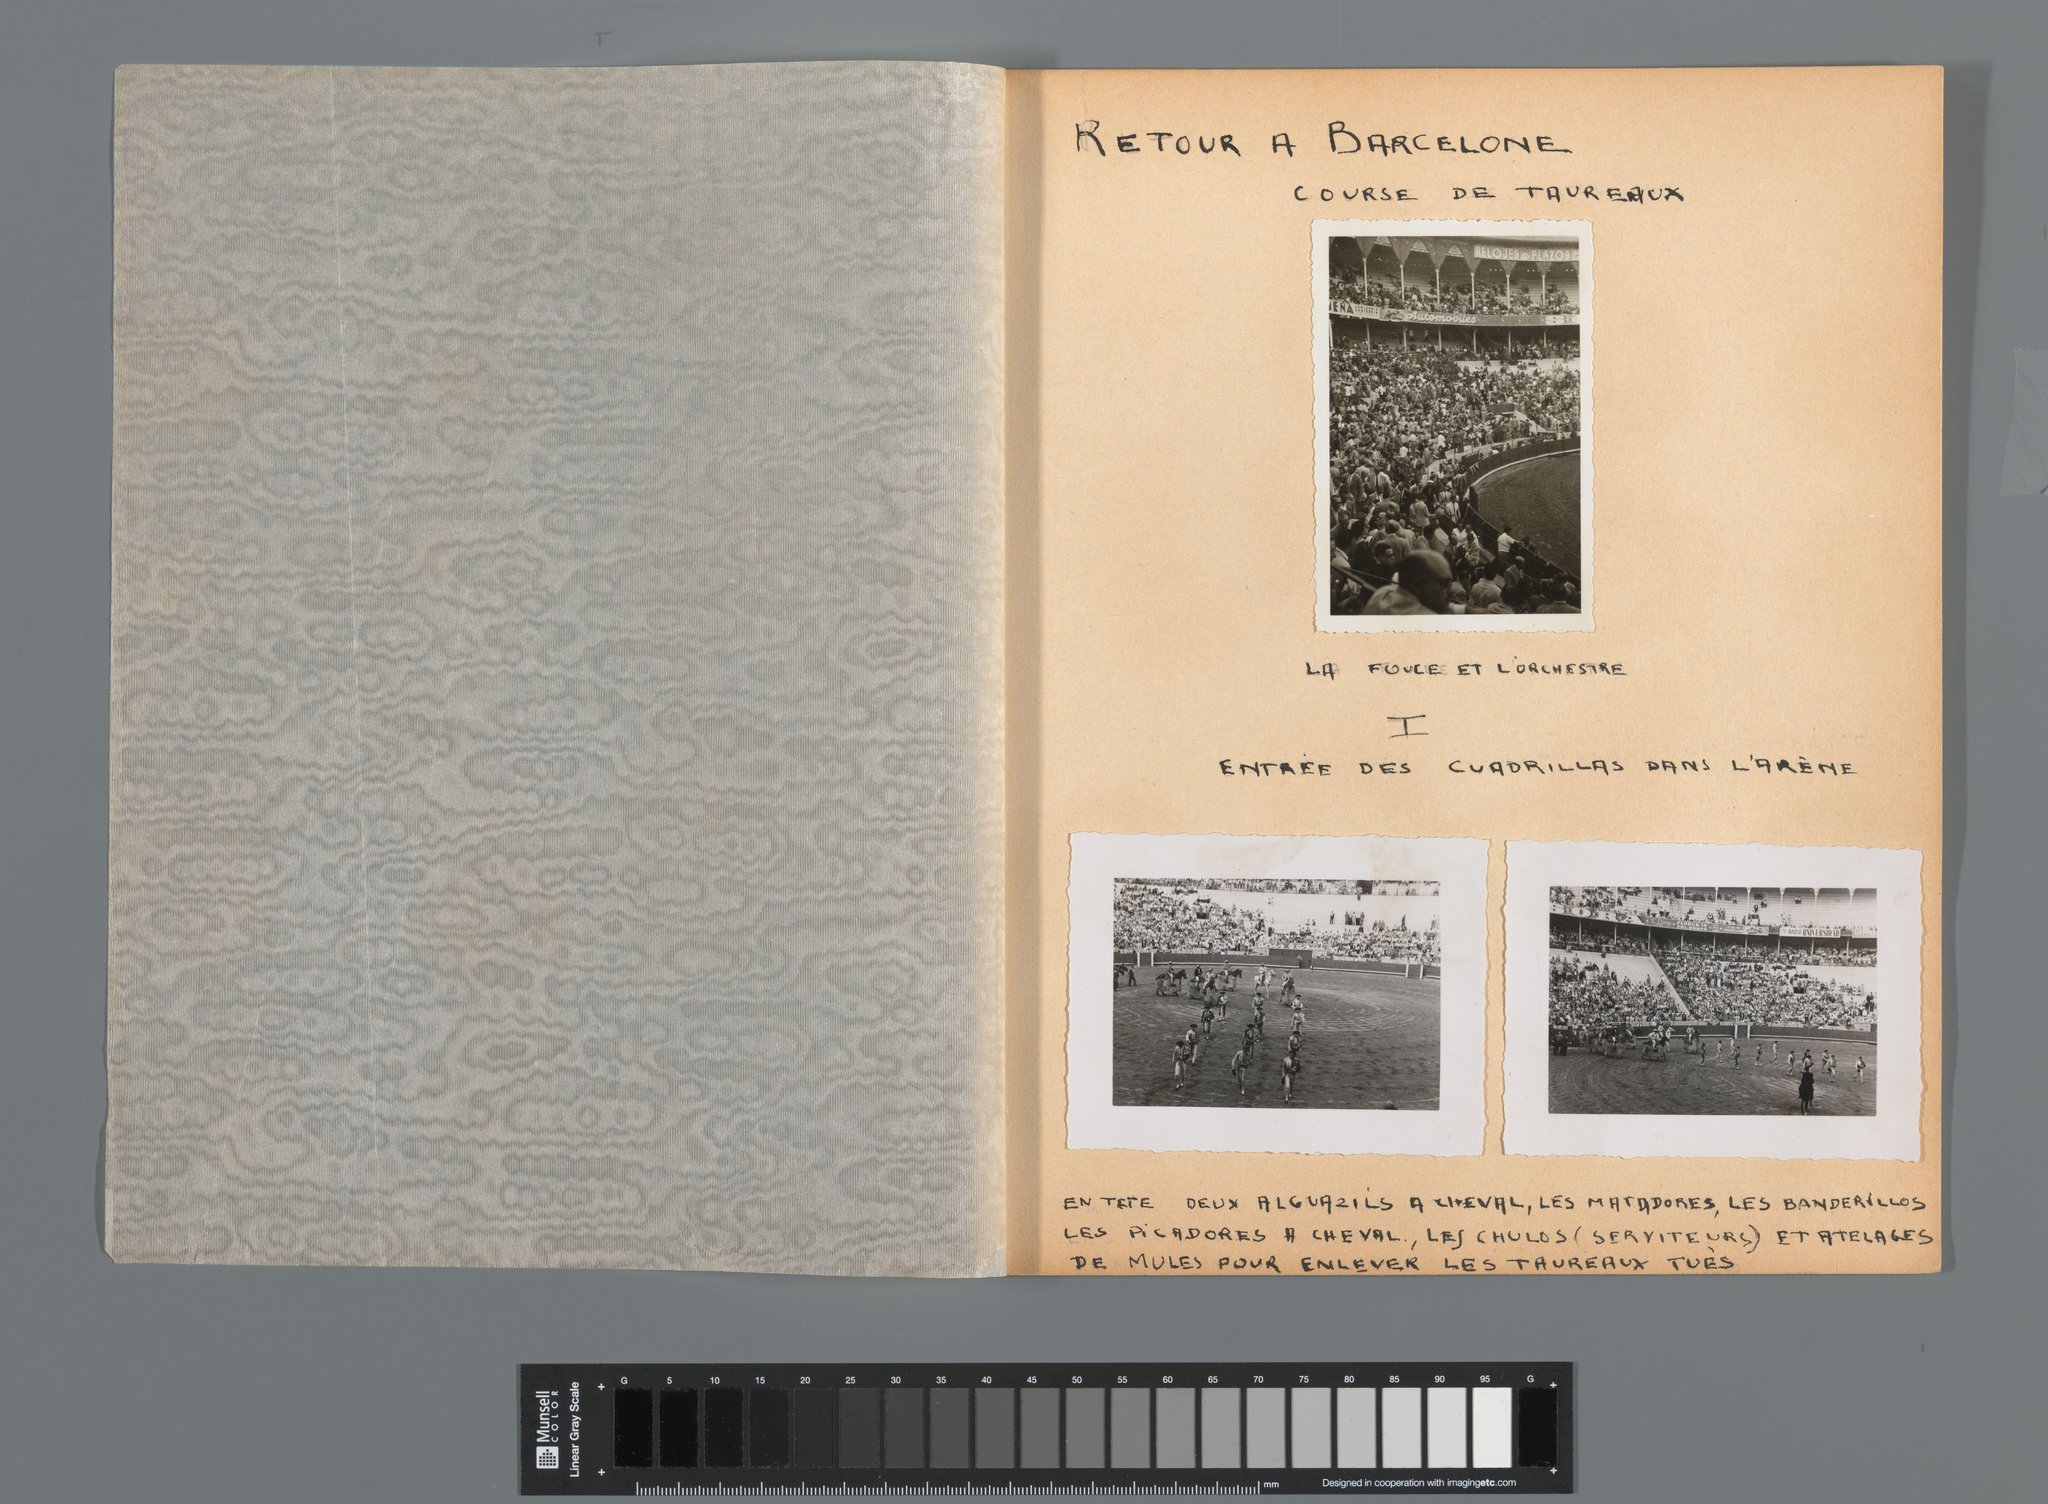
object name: photograph album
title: Fotoalbum van een stierengevecht in Barcelona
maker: Anonymous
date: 1955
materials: paper, ink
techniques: gelatin silver print, writing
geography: france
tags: bullfight, bull-fighter, toreador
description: Fotoalbum met twaalf foto's, verdeeld over vier pagina's. De foto's zijn waarschijnlijk door één anonieme Franse amateurfotograaf gemaakt, tijdens een stierengevecht in Barcelona.